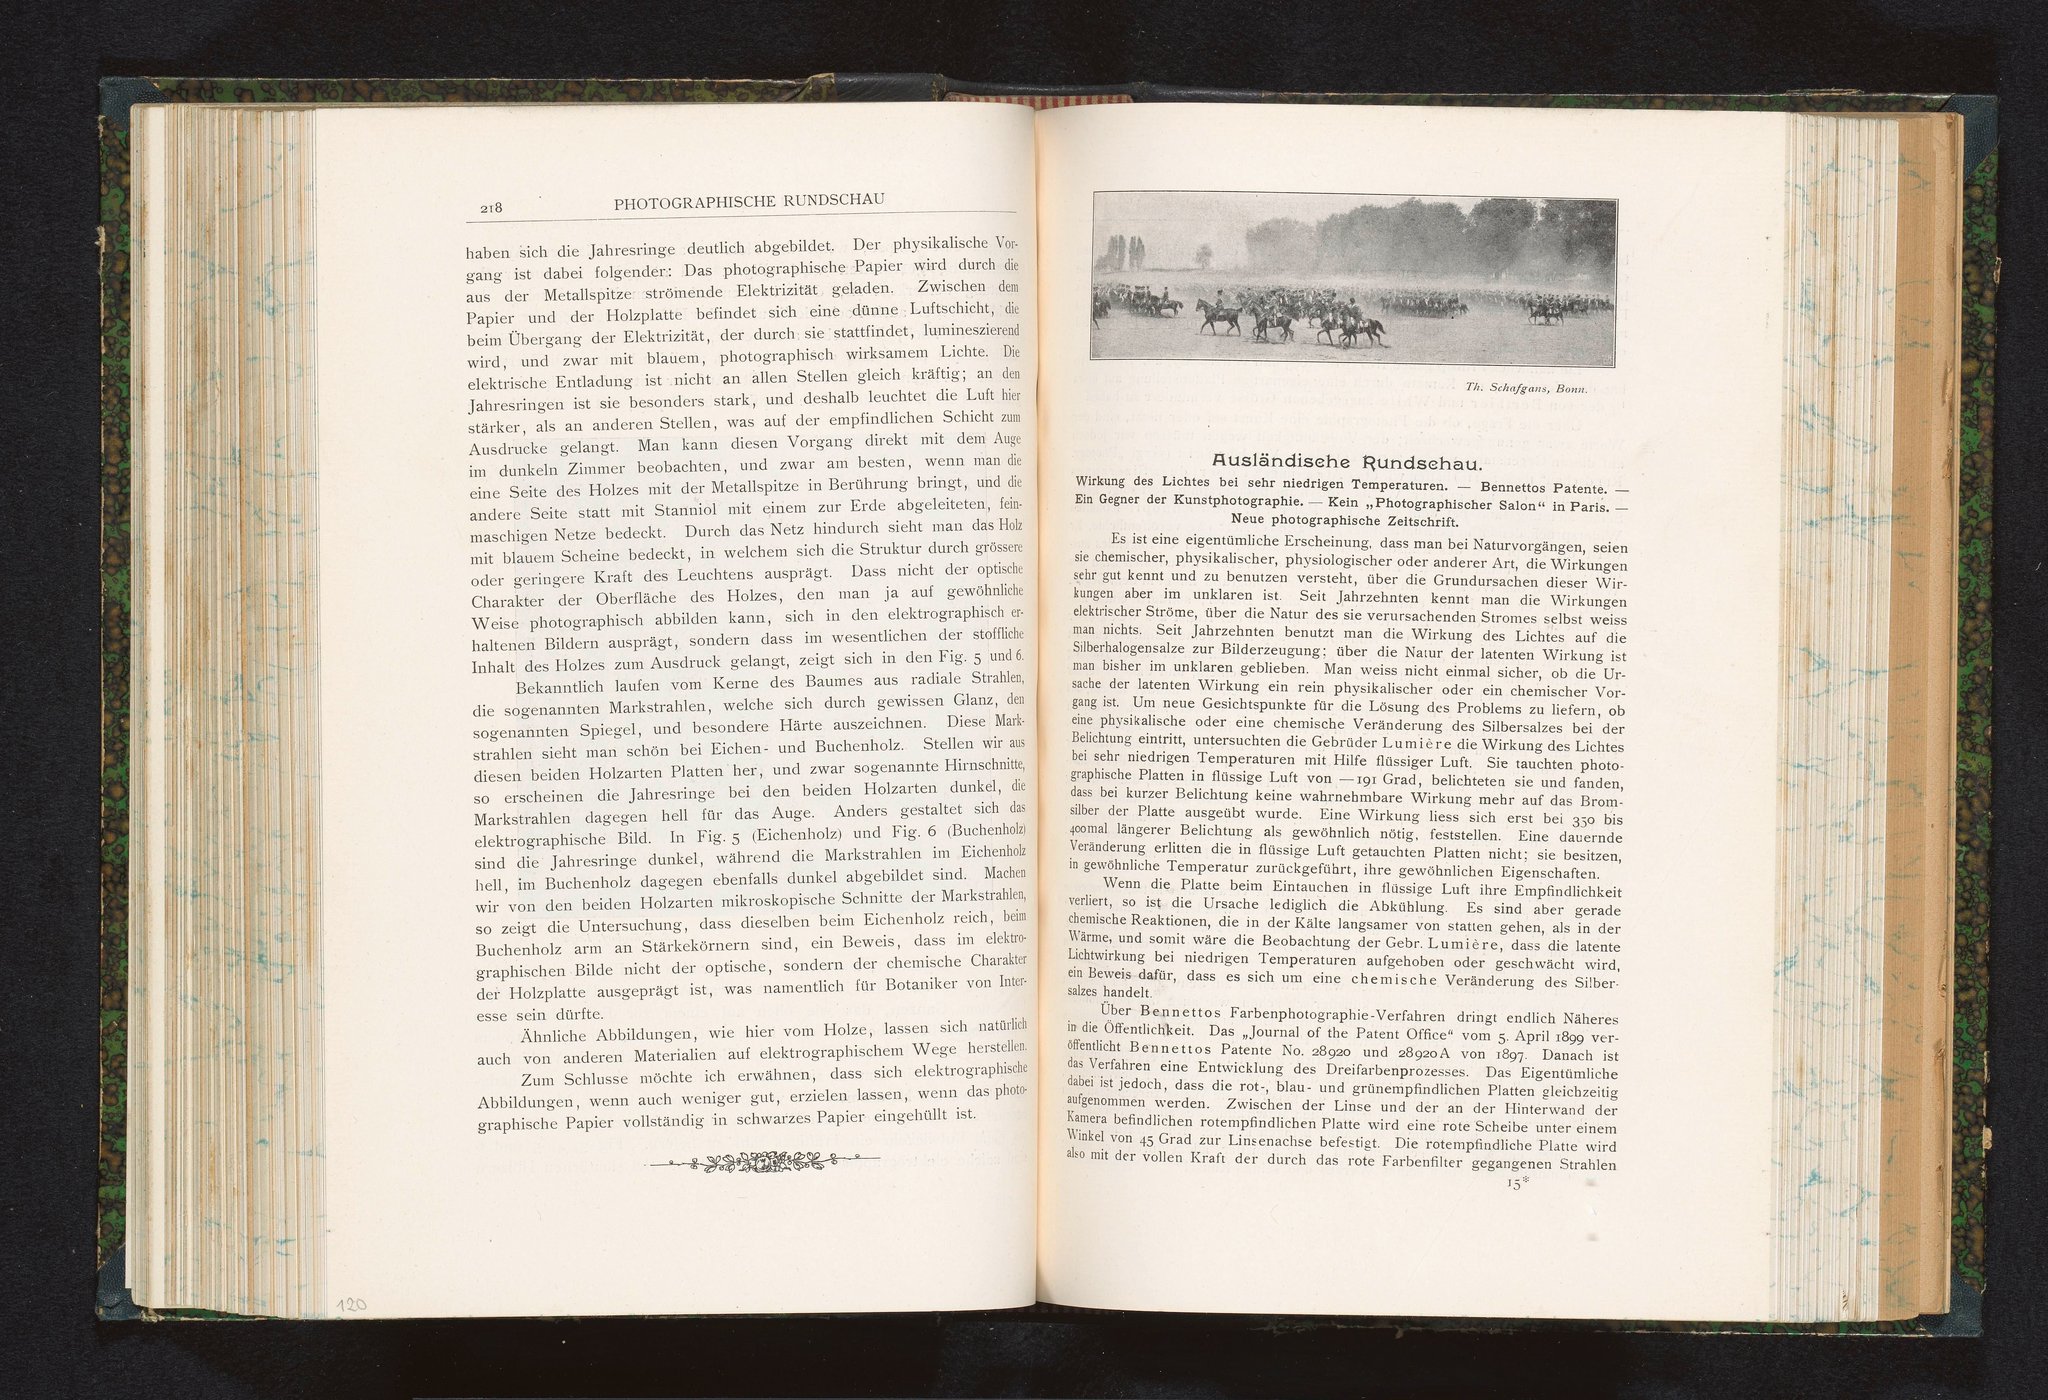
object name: photomechanical print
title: Manschappen te paard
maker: theodor schafgans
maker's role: fotograaf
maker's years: 1859-1907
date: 1894-1899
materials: paper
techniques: autotype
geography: berlin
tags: riding a horse, ass, or mule; rider, horseman